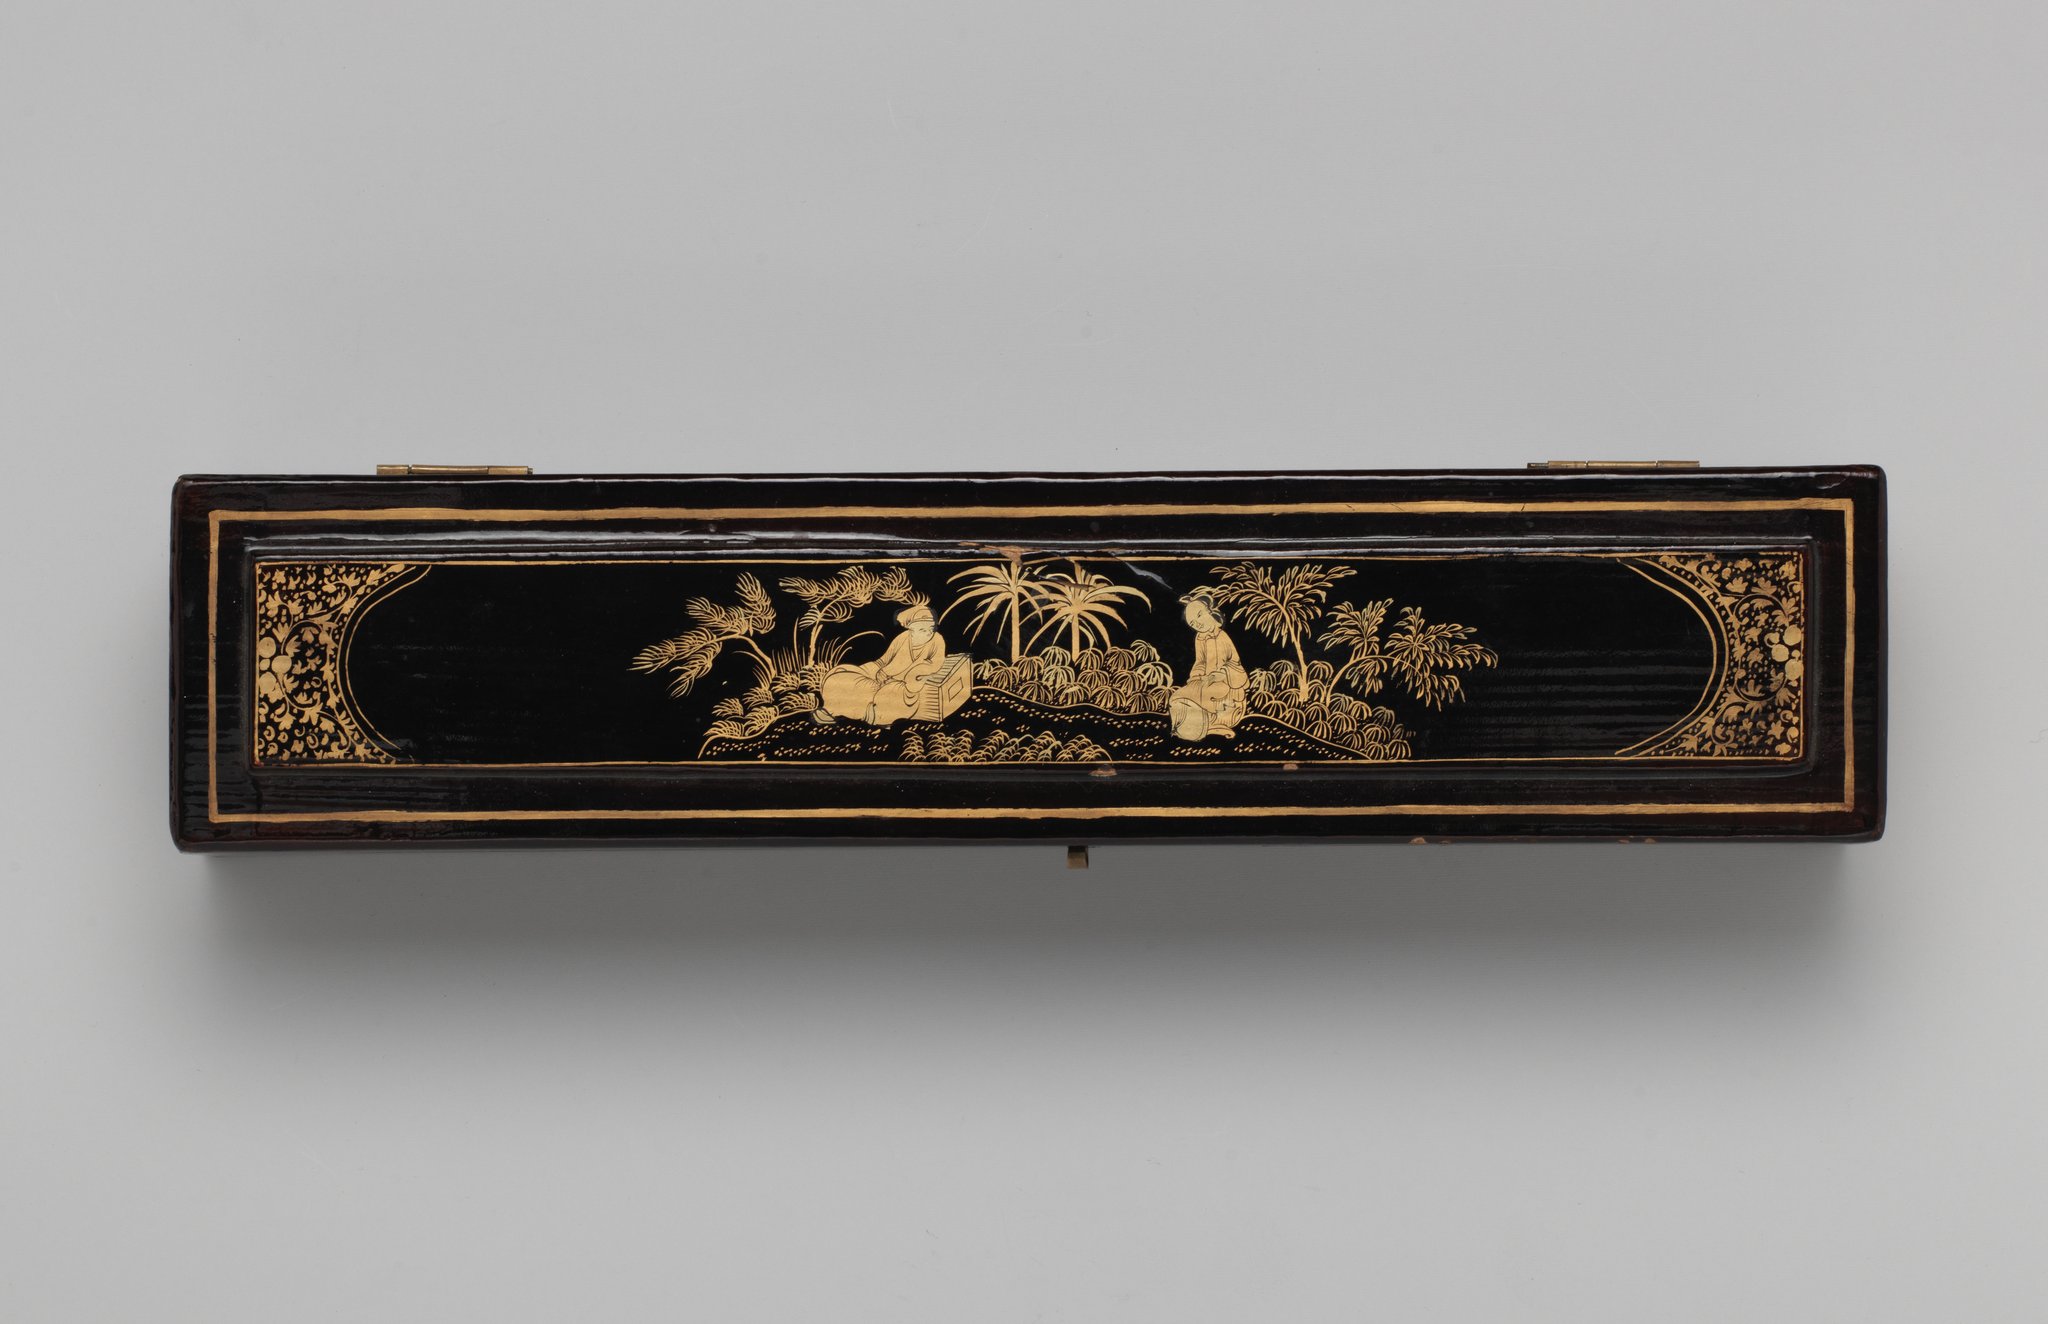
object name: fan box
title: Fan case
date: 1801-1900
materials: wood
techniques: lacquer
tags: human figures,trees